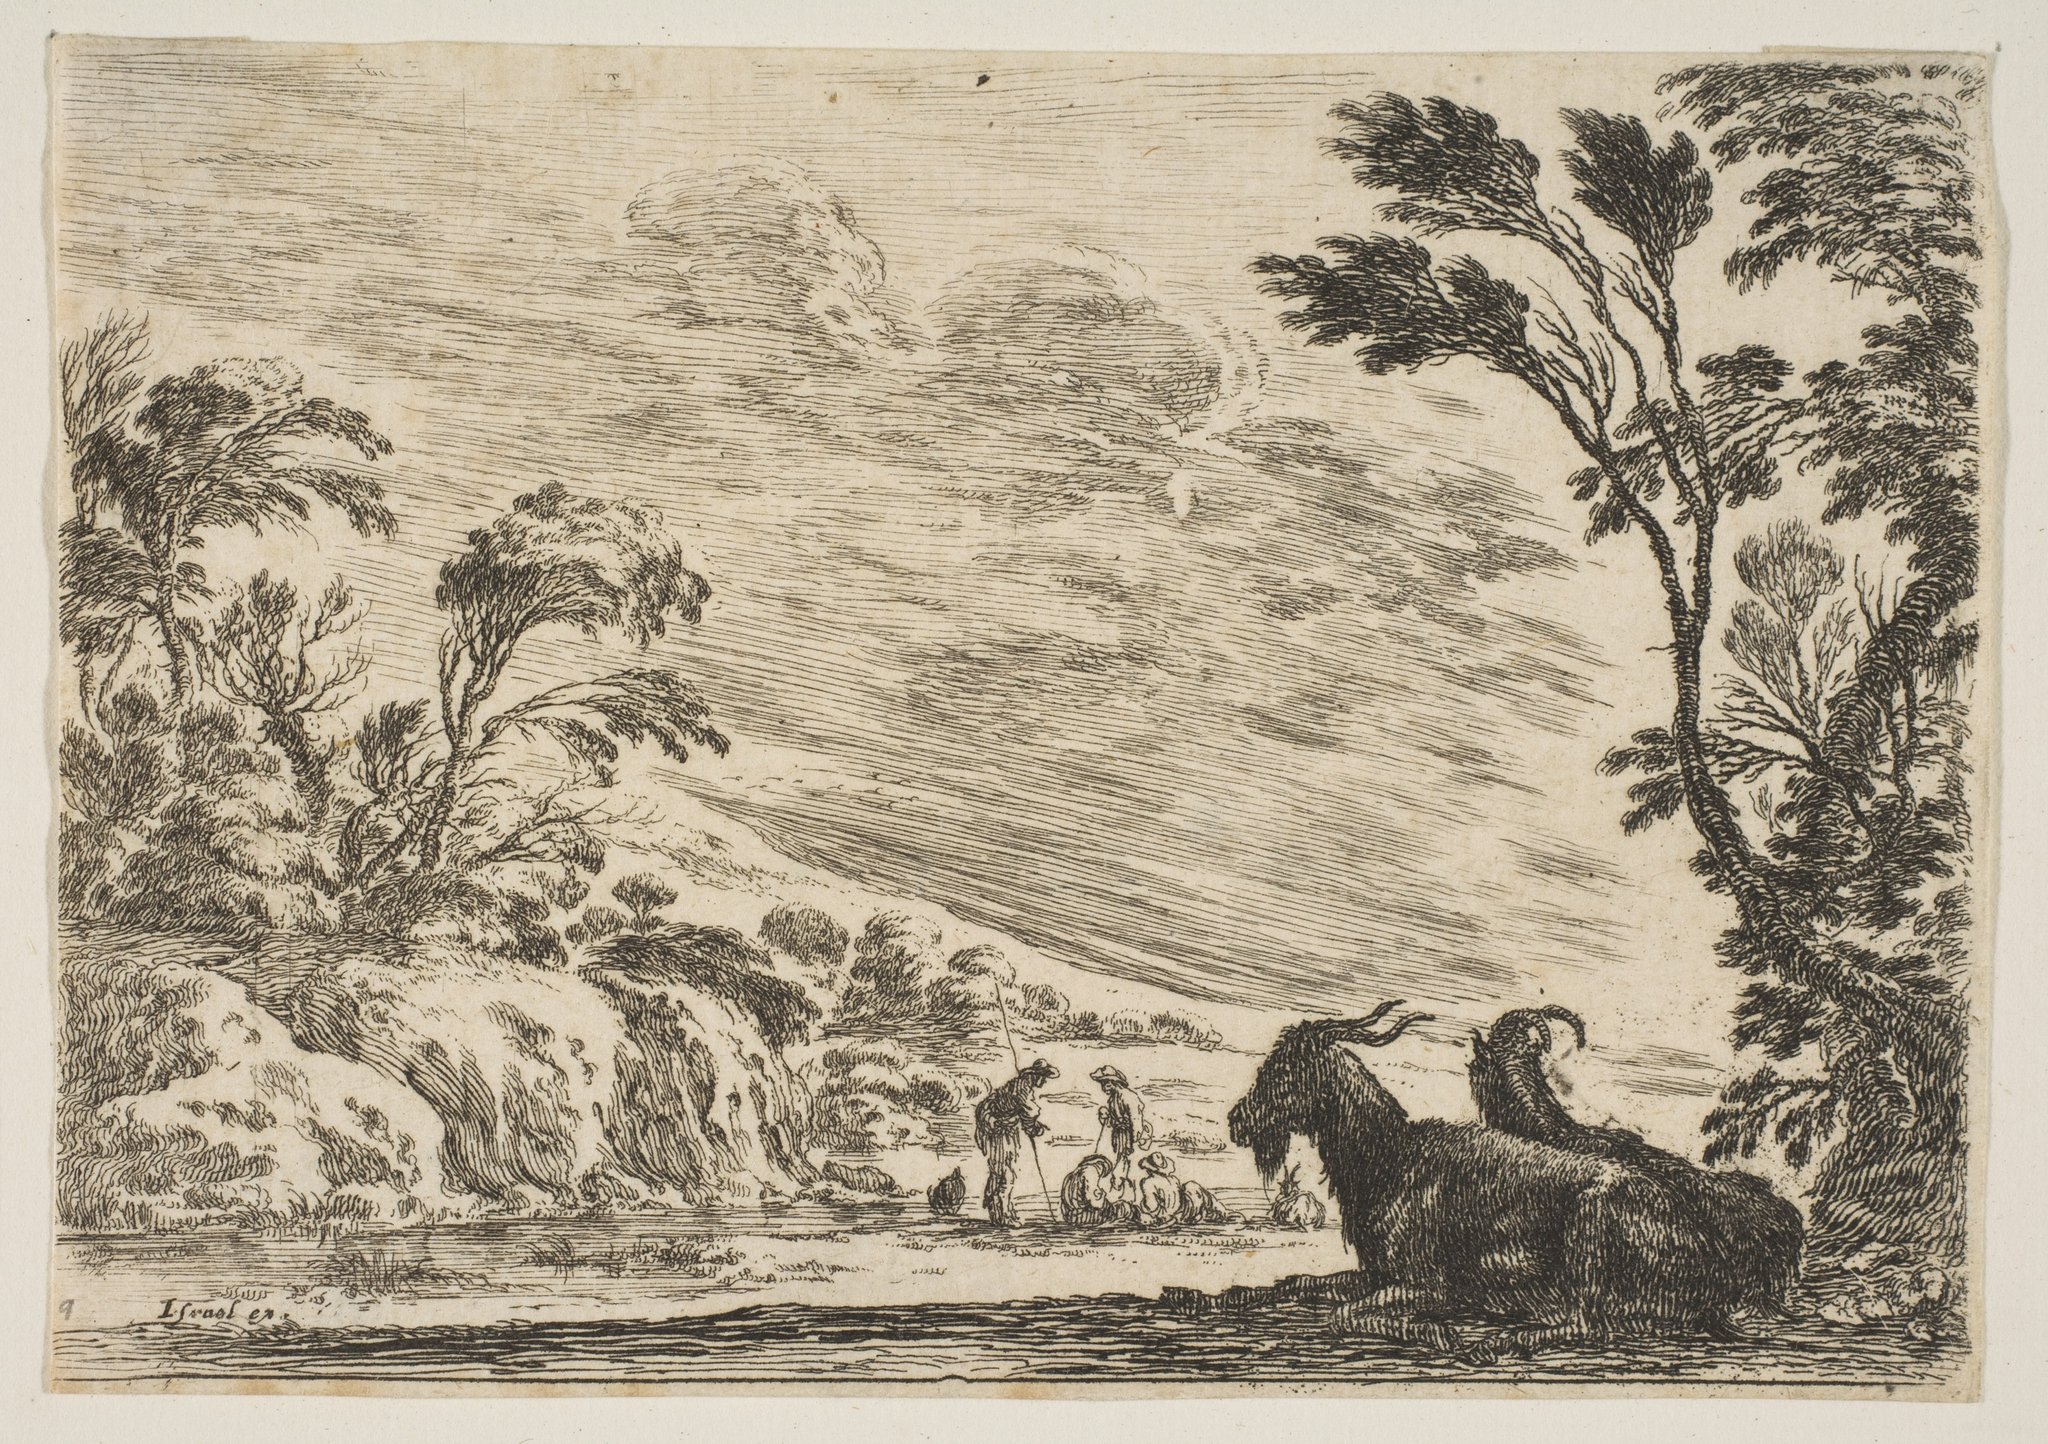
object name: print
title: Two goats resting to right, turned towards the left, four men and a horse in a river in the background, plate 9 from "Various Figures" (Agréable diversité de figures)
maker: stefano della bella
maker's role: artist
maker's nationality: italian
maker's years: 1610-1664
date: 1642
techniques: etching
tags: men,goats,horses,rivers,trees